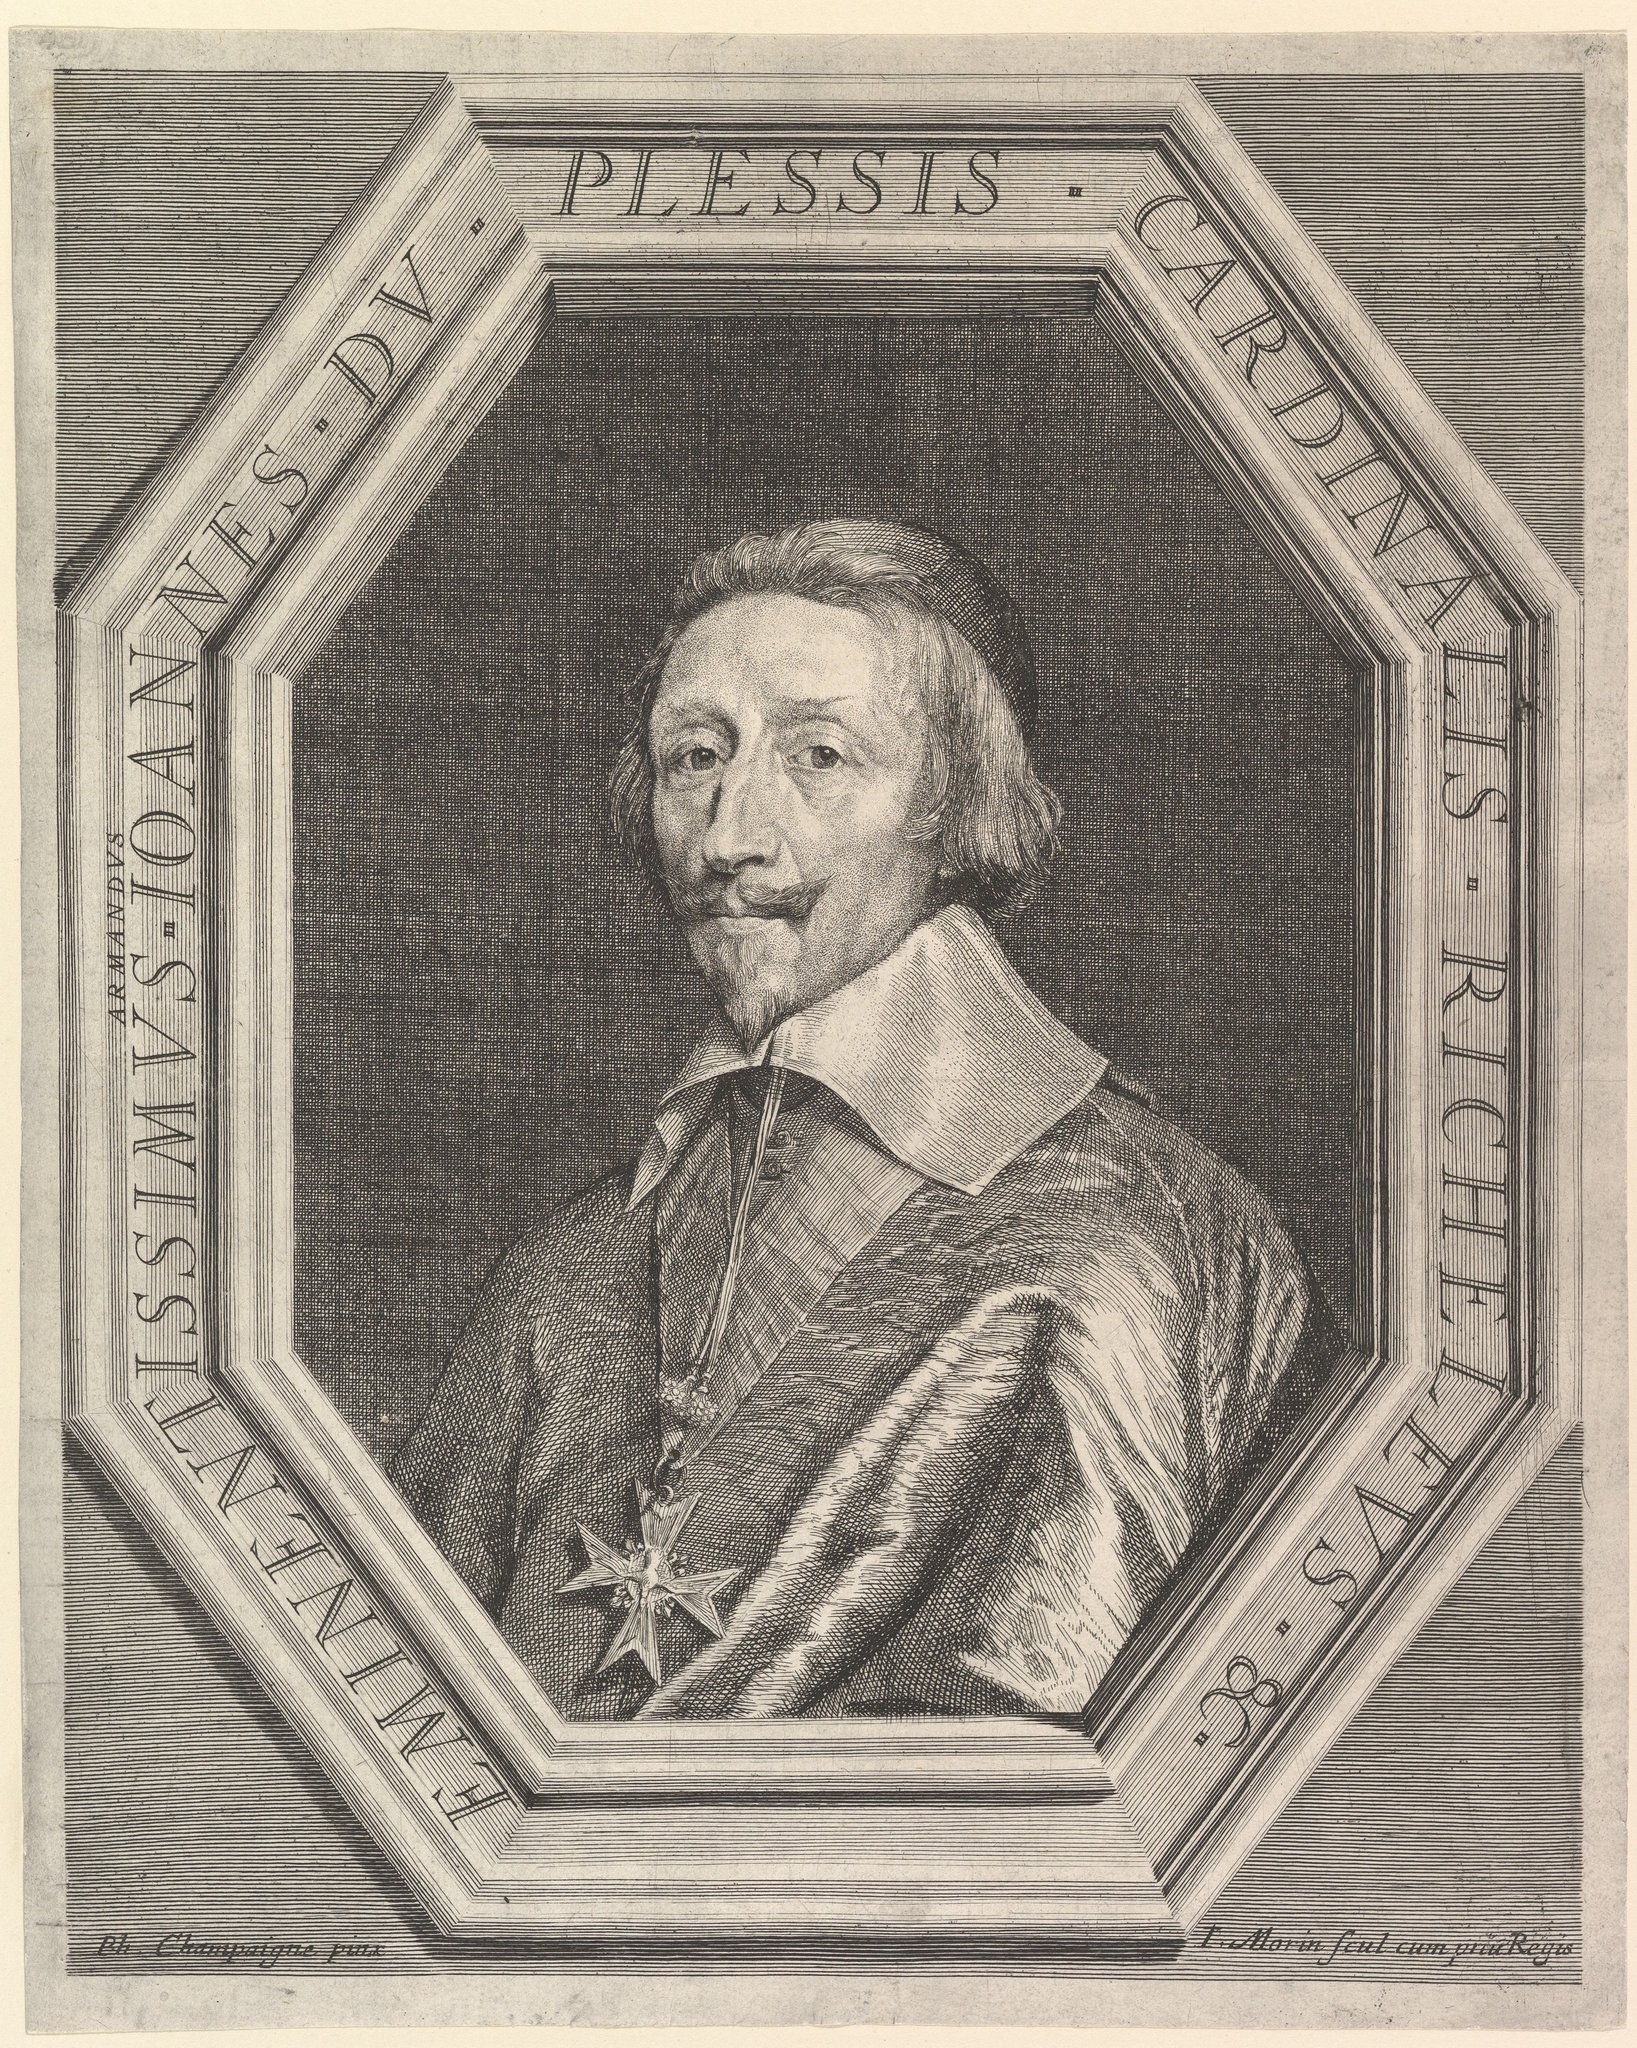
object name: print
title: Cardinal de Richelieu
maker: jean morin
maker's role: artist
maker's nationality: french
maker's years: 1605-1650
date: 1605-1650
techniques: etching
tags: men,portraits